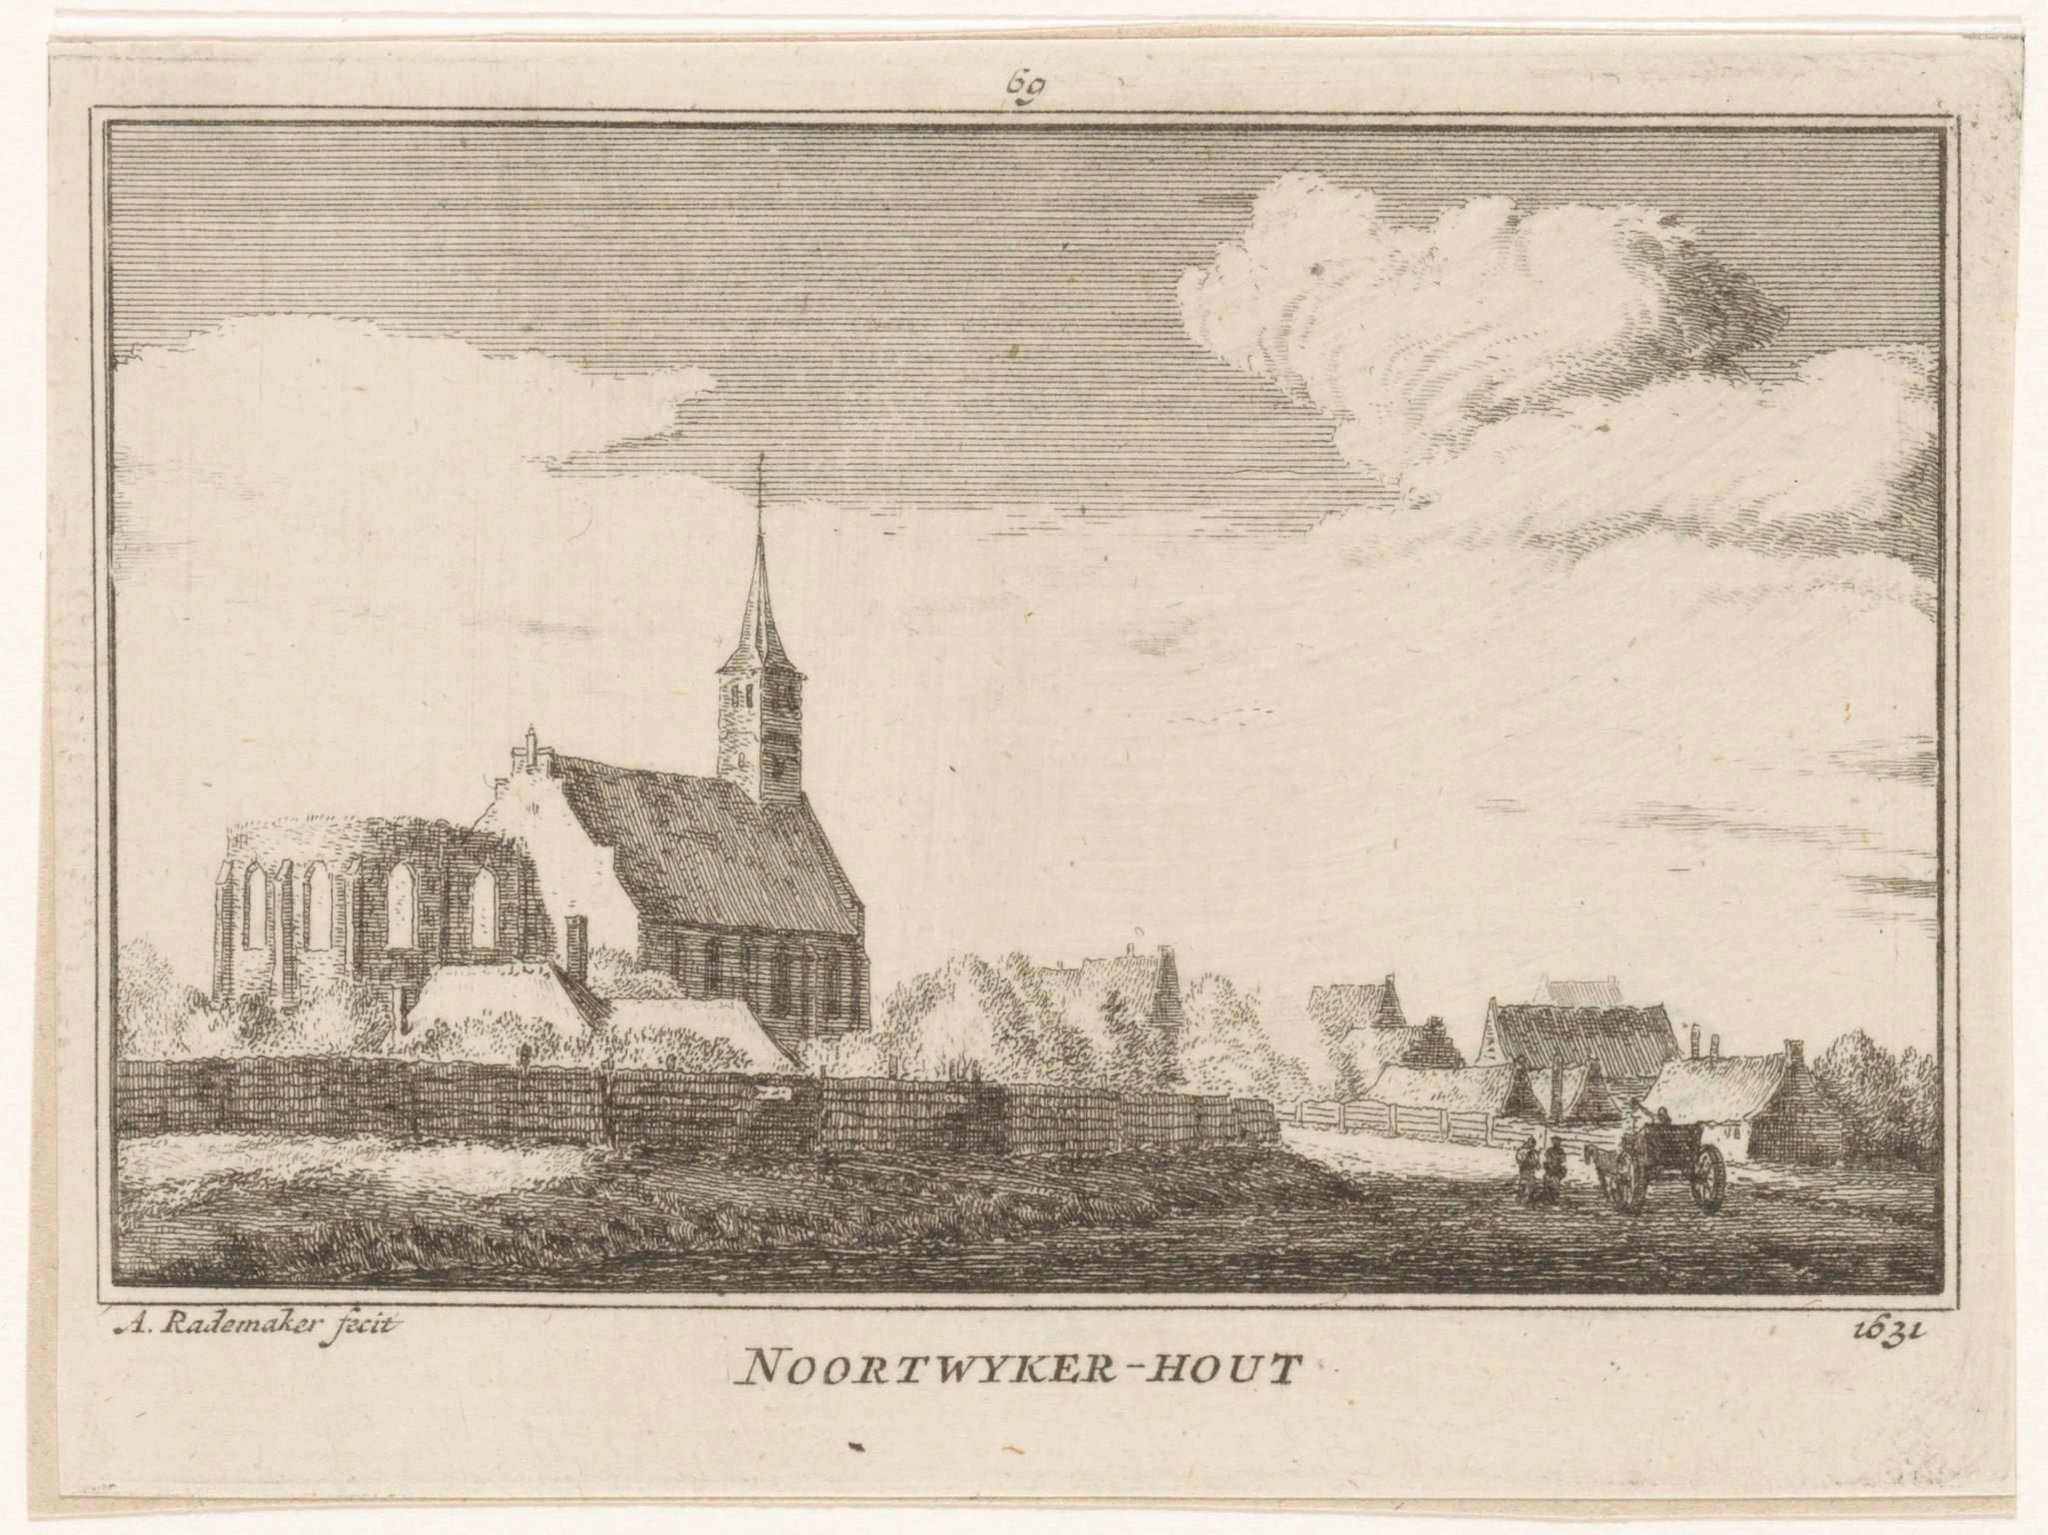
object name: book illustration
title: Noortwyker-Hout 1631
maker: abraham rademaker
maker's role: draughtsman, print maker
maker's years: 1676-1735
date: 1725-1803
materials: paper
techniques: engraving, etching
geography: amsterdam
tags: prospect of village, silhouette of village, church (exterior), ruin of church, monastery, etc., two-wheeled vehicle drawn by one animal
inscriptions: collector's mark: Lugt 2228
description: Prent ook gebruikt in: Rademaker, Abraham. Kabinet van Nederlandsche outheden en gezichten: vervat in 300 konstplaaten (…). 2 delen. Amsterdam: Willem Barents, 1725, dl. 1, ill. 69. Na 1725 is deze prent nog in verschillende heruitgaven verschenen, uitgegeven in 1727-1733, 1770-1771 en 1792-1803. Uit welke uitgave het huidige exemplaar precies komt is niet na te gaan.